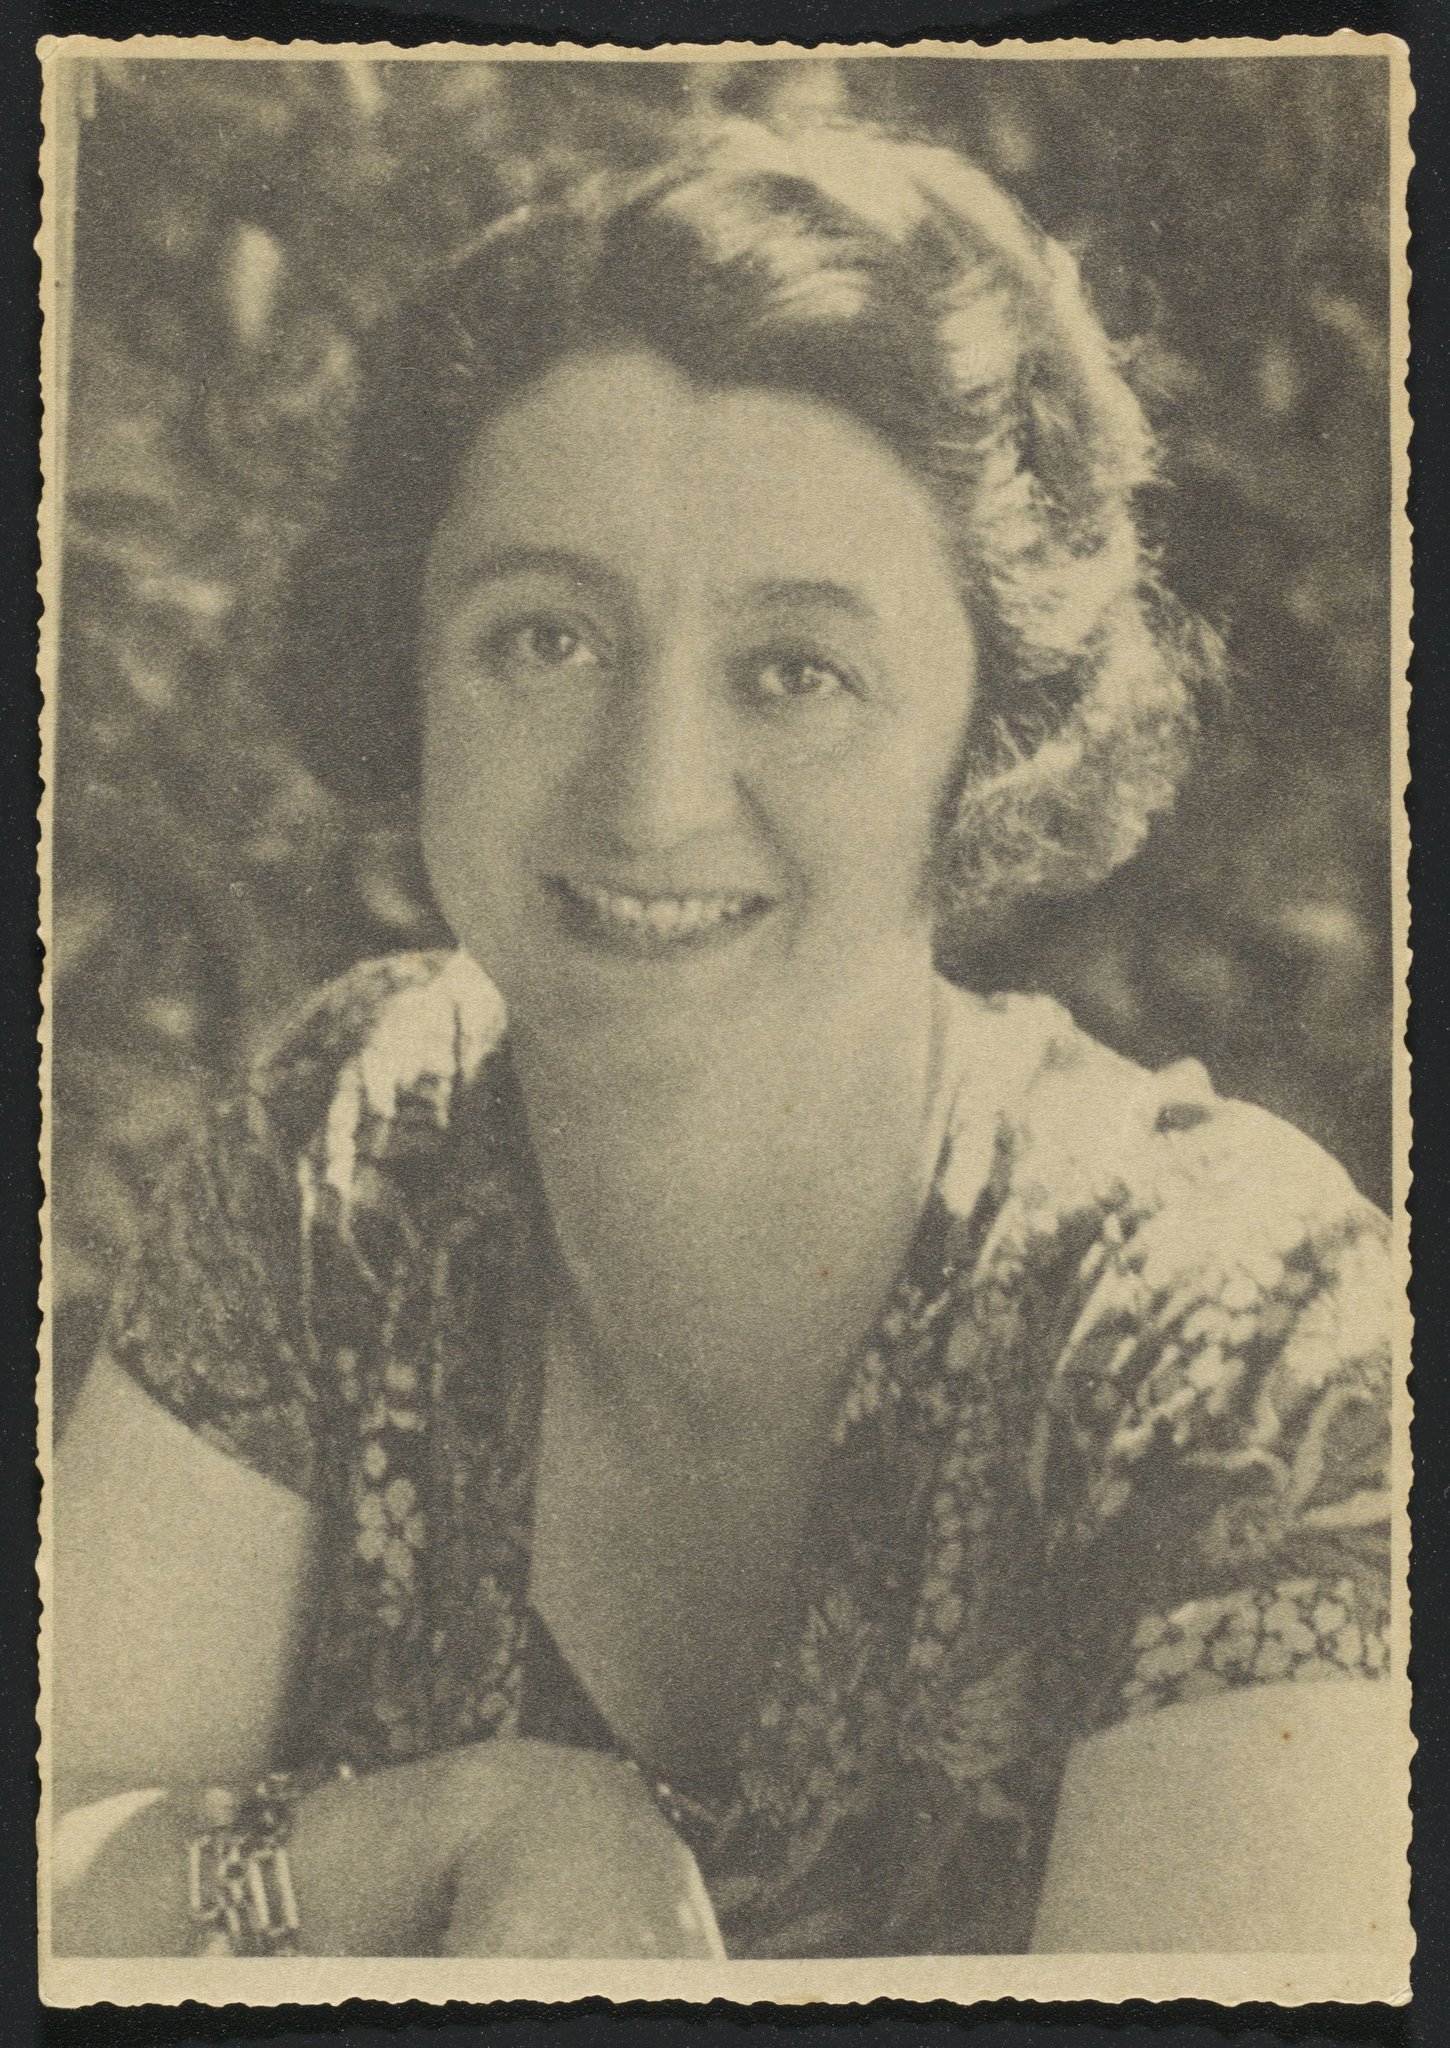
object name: photograph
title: Portret van Denise Vande Velde-Borgeaud, eigenaar van gesloten modehuis in Brussel en Londen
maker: Anonymous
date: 1930-1936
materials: paper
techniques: photography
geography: brussels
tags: denise vandervelde-borgeaud, adult woman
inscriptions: inscription: ‘Denise Vanderveld-Borgeaud’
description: Denise Vande Velde-Borgeaud kijkt recht in de camera en lacht. Zij heeft kort golvend haar, dat vanaf het voorhoofd naar achteren is gekamd. Zij draagt (vermoedelijk) een gebloemde japon met een diepe V-hals waar een laaggesneden, effen donker hemd of blouse in te zien is. Om haar rechteronderarm een aantal armbanden: twee met grote rechthoekige schakels en een met ronde schakels.